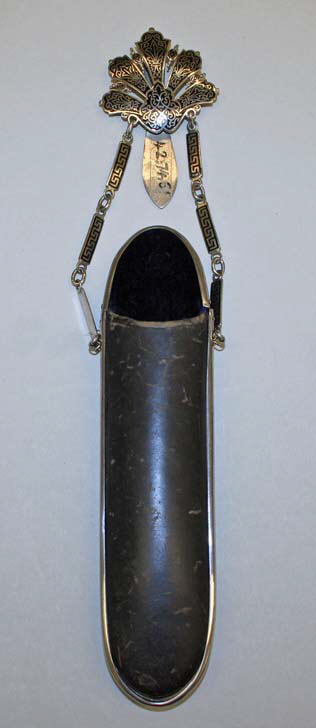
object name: case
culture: american or european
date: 1850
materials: metal